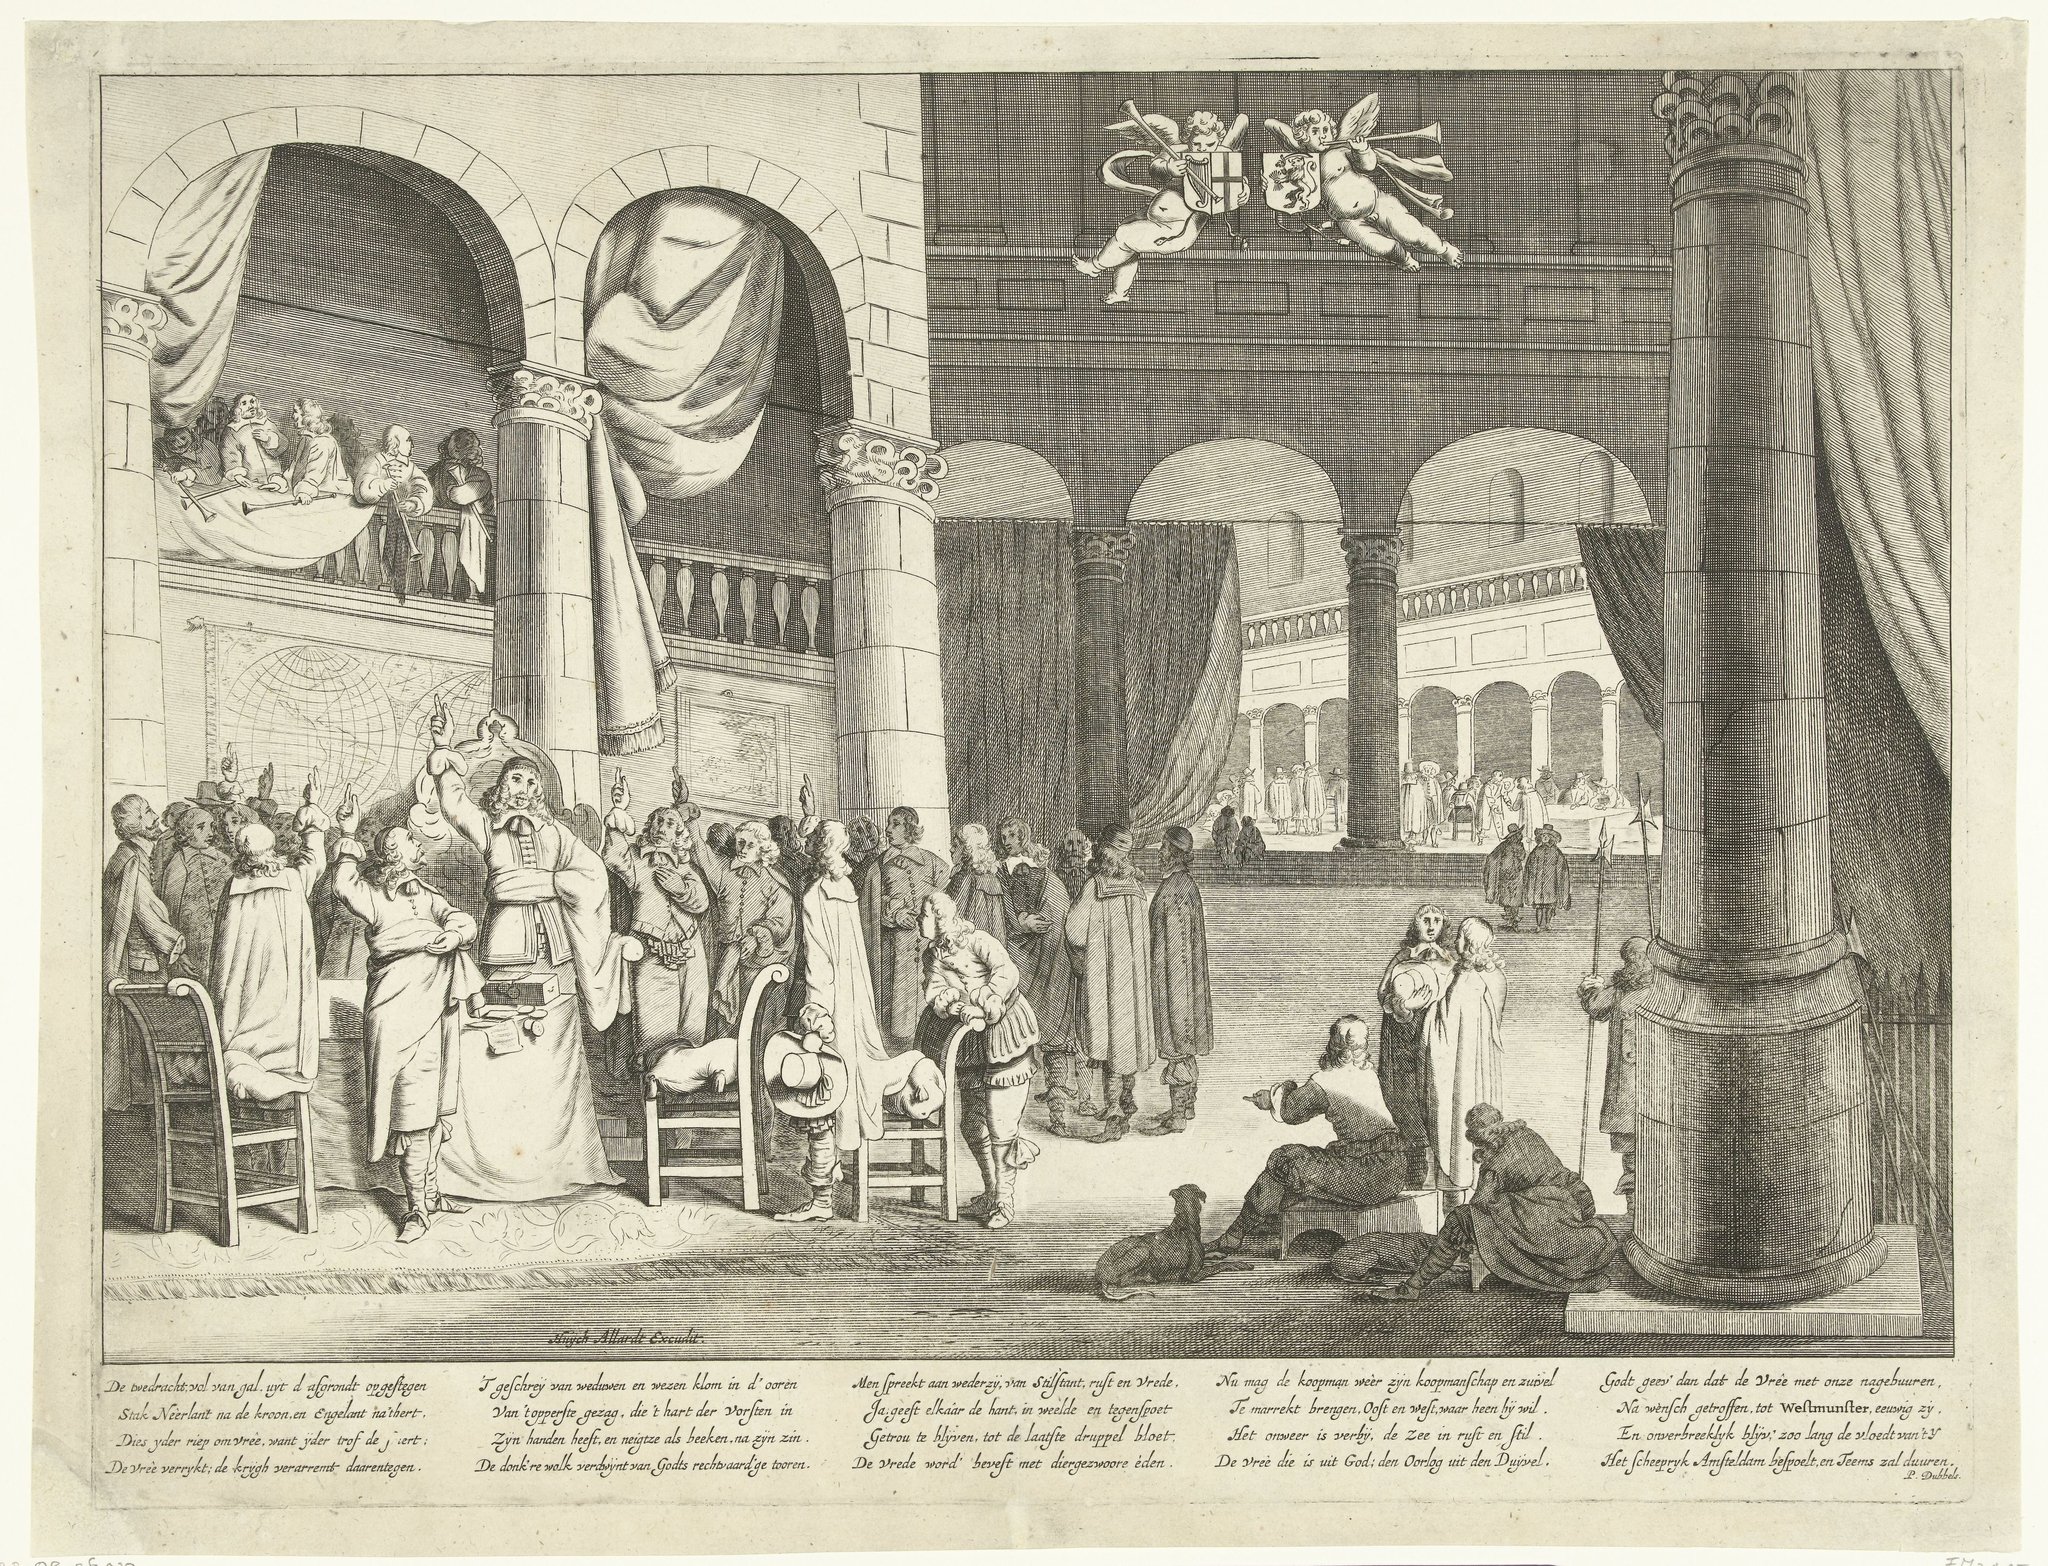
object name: print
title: Vrede van Westminster, 15 april 1654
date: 1654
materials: paper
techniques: engraving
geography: northern netherlands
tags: signing of peace treaty, concluding the peace, swearing an oath (with two fingers raised)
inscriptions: poem: ‘De twedracht vol van gal...’, address: ‘Huygh Allardt’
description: Vrede tussen Verenigde Provincies en Engeland, gesloten te Westminster, op 15 April 1654, waarmee een einde komt aan de Eerste Engelse Oorlog. Open hal of zuilengang in een paleis met op de voorgrond links een tafel, waaromheen enkele personen met opgeheven hand de eed zweren. Bovenaan twee engelen met wapens van de Republiek en Engeland. In het onderschrift vijf vierregelige verzen.